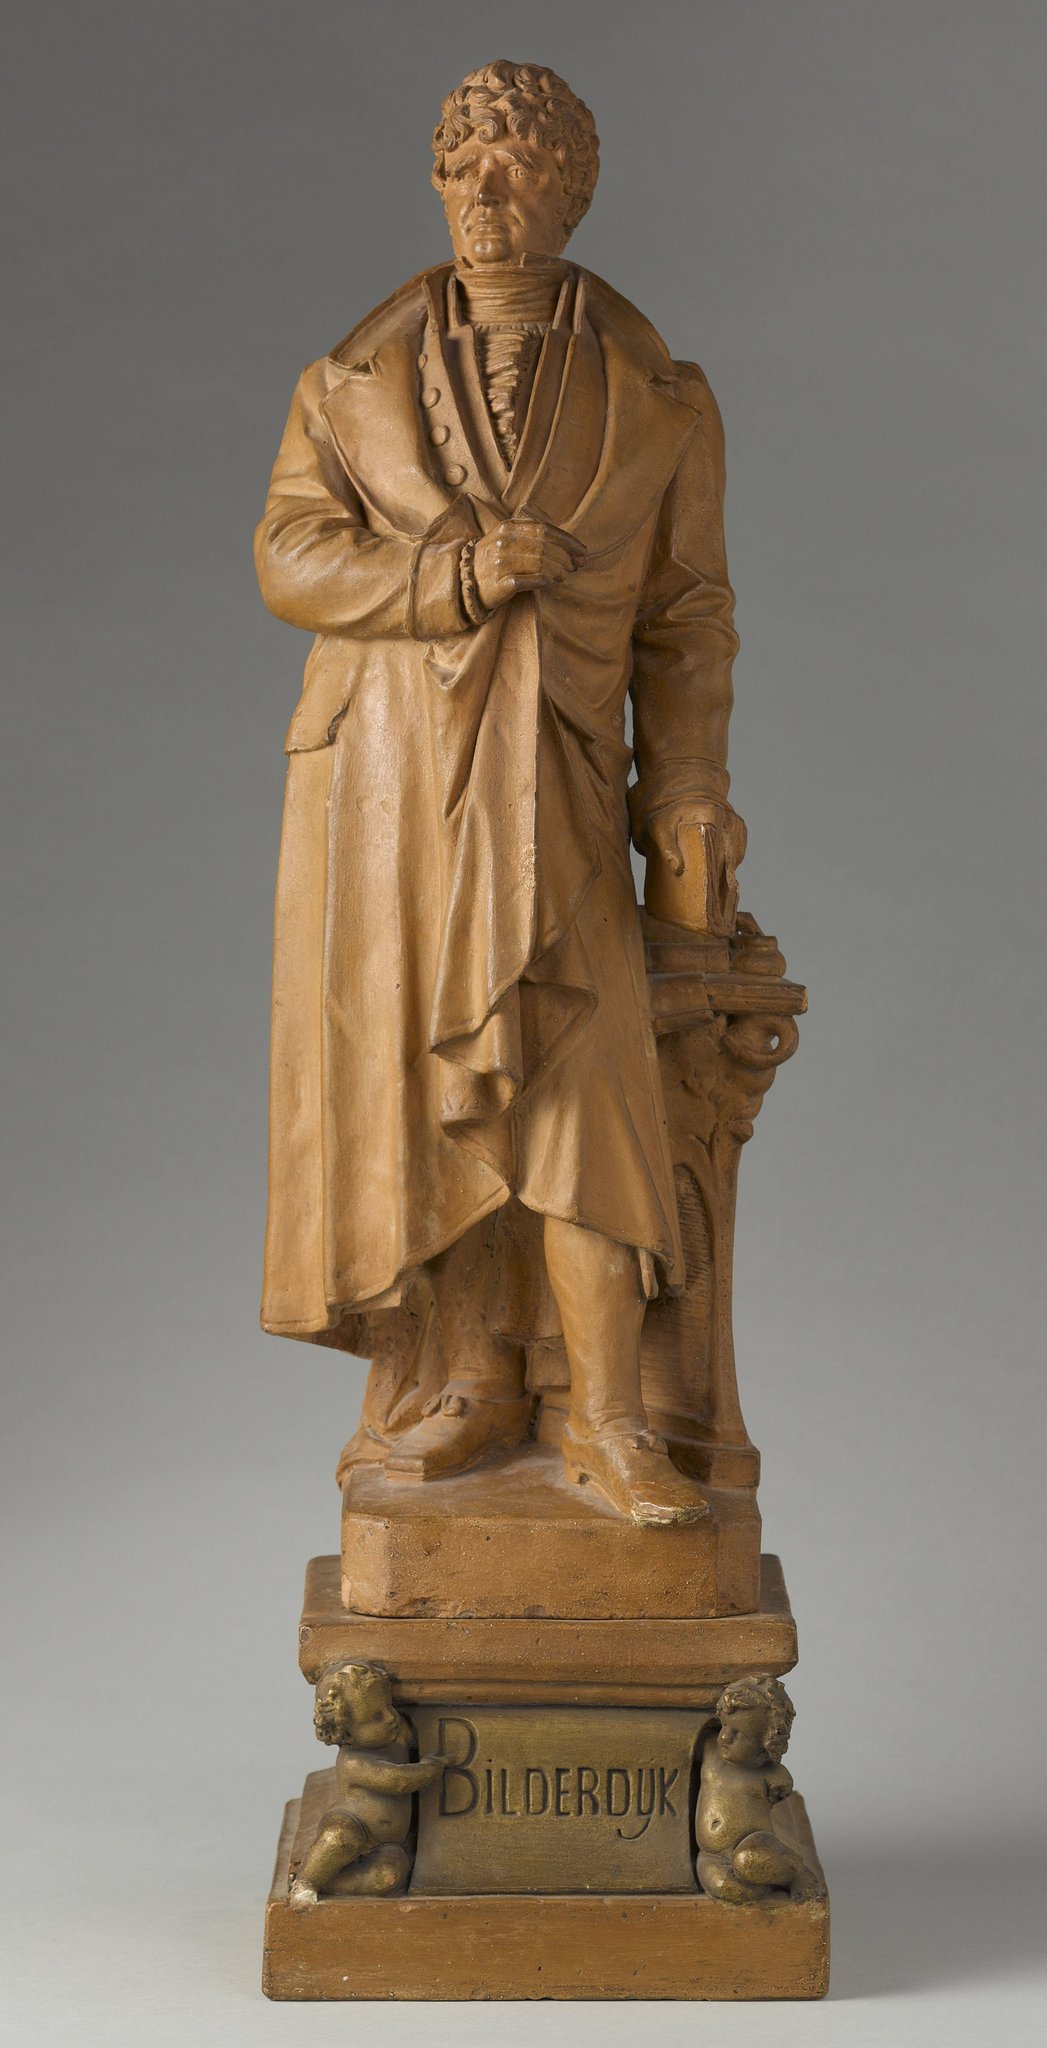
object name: figure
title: Beeld van Willem Bilderdijk, dichter en geschiedschrijver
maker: jean theodor stracké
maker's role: sculptor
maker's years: 1817-1891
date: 1877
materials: terracotta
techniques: gilding, molding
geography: den bosch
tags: amsterdam, haarlem, print maker, draughtsman, willem bilderdijk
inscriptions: inscription: ‘BILDERDIJK’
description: Beeld van Willem Bilderdijk, staand met linkerbeen naar voren. Met de rechterhand houdt hij zijn mantel bij de borst dicht. In de linkerhand houdt hij een boek. Rechts naast hem een taboeret waarop twee boeken, papier en een inktkoker met pen. Hij heeft krullend haar, draagt een jabot en een hemd met hoe boord waaromheen een brede cravatte is gewonden, kusen en schoenen met stompe neuzen strikken.